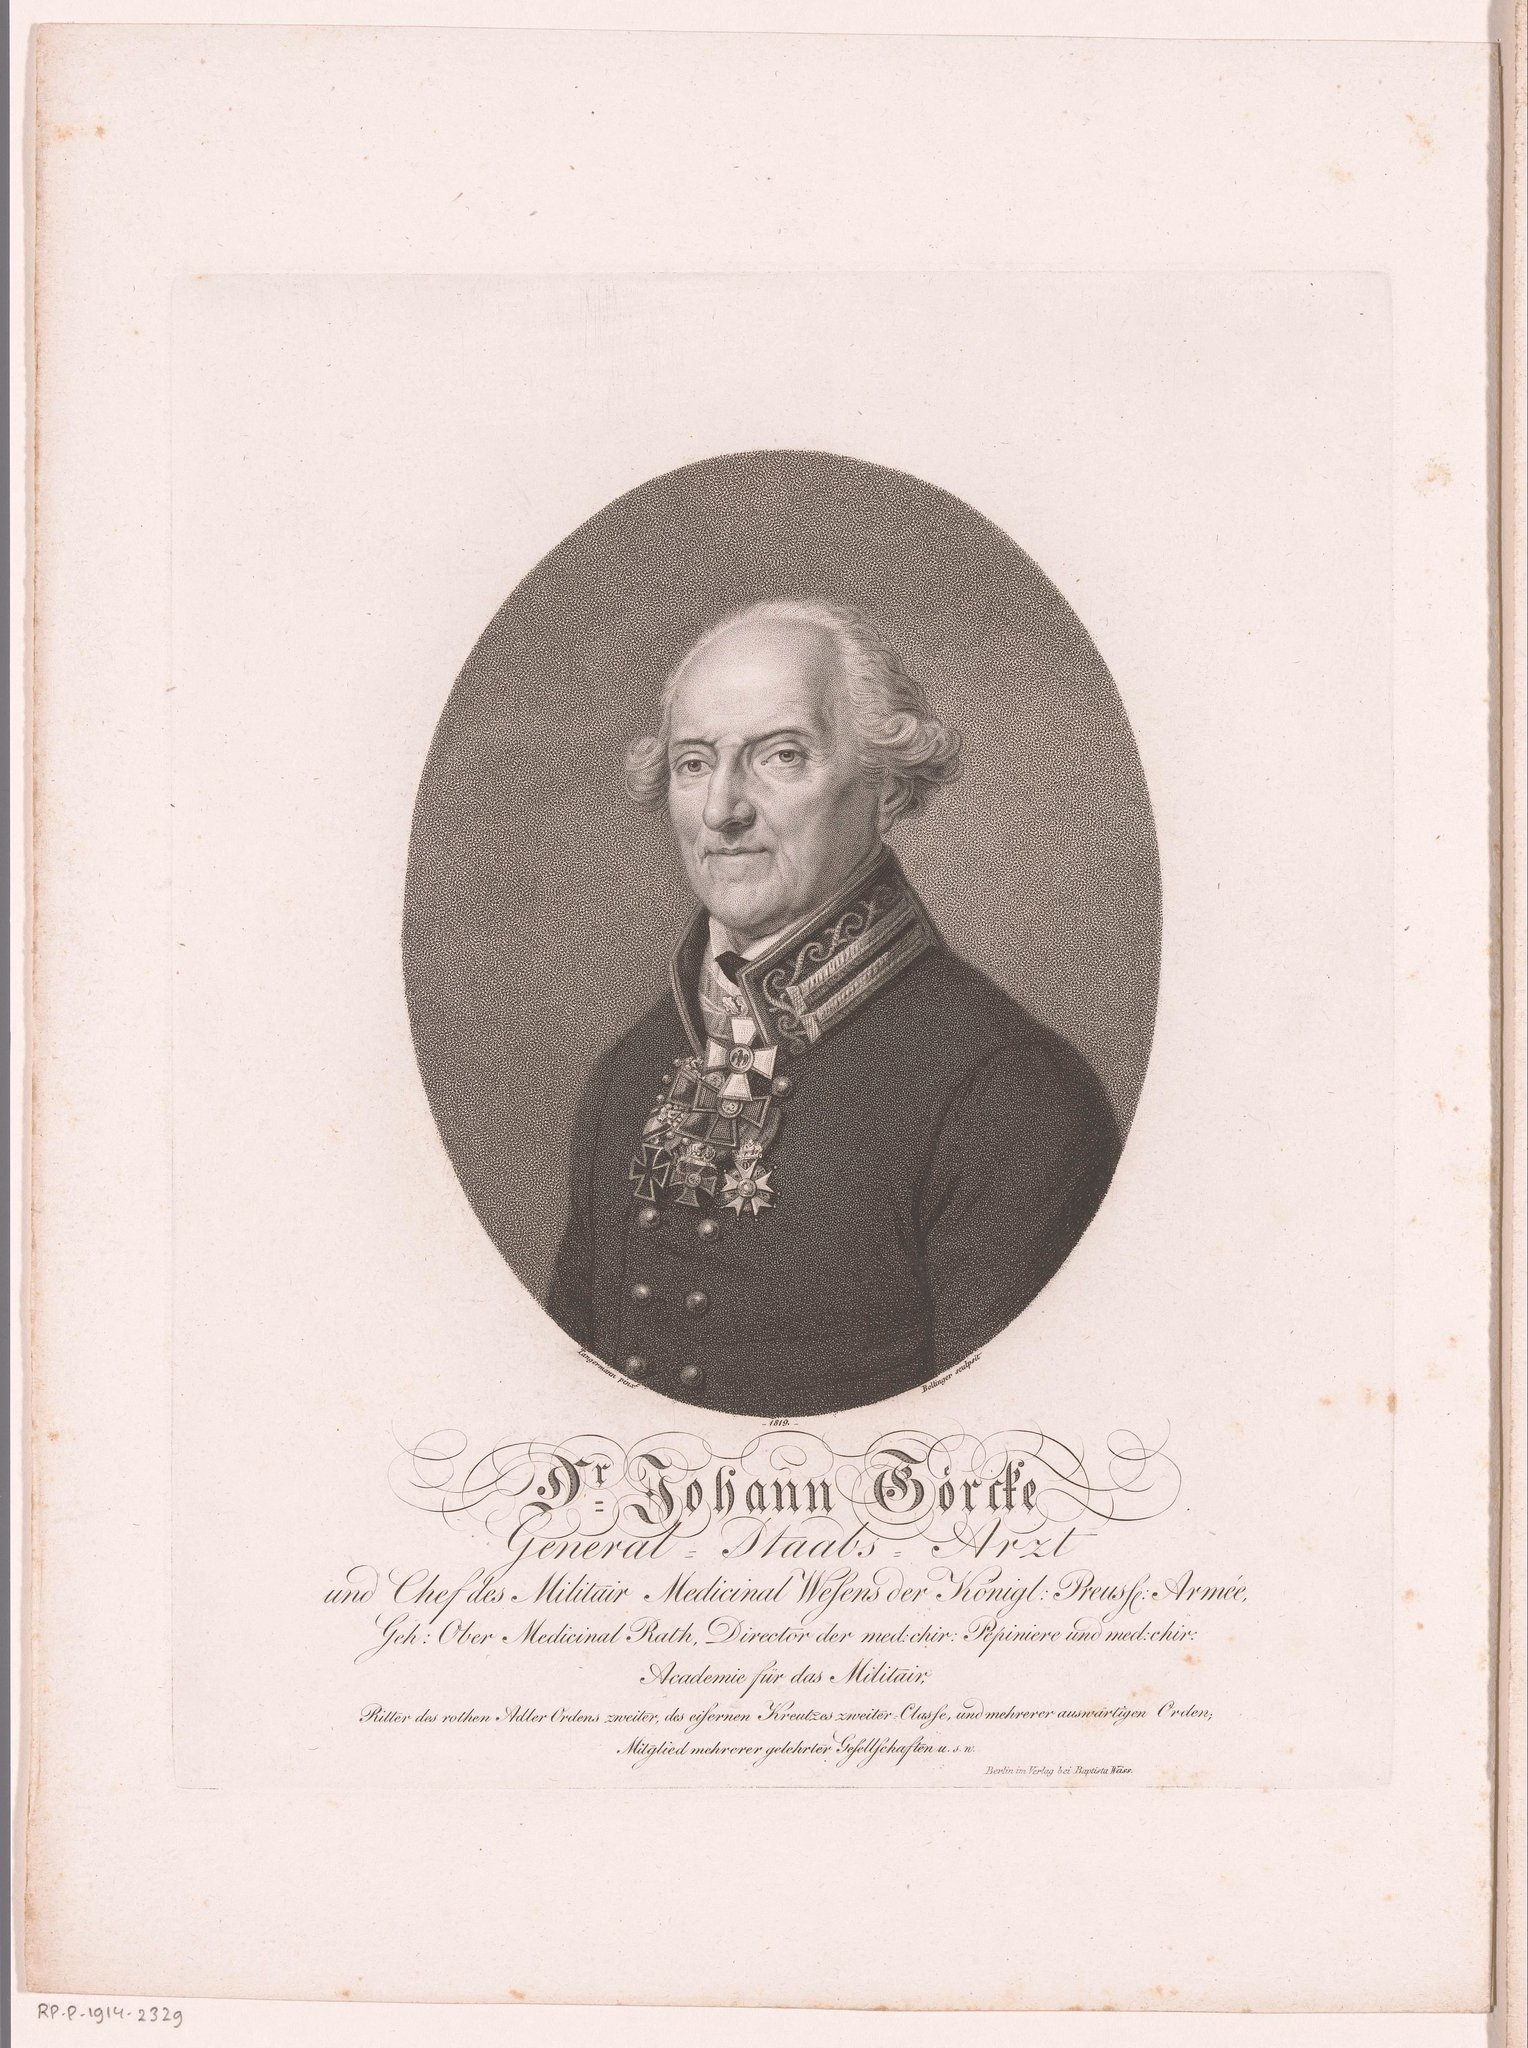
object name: print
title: Portret van Johann Goercke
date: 1819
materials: paper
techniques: engraving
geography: weimar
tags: knighthood order, historical persons, (military) uniforms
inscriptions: collector's mark: Lugt 2228